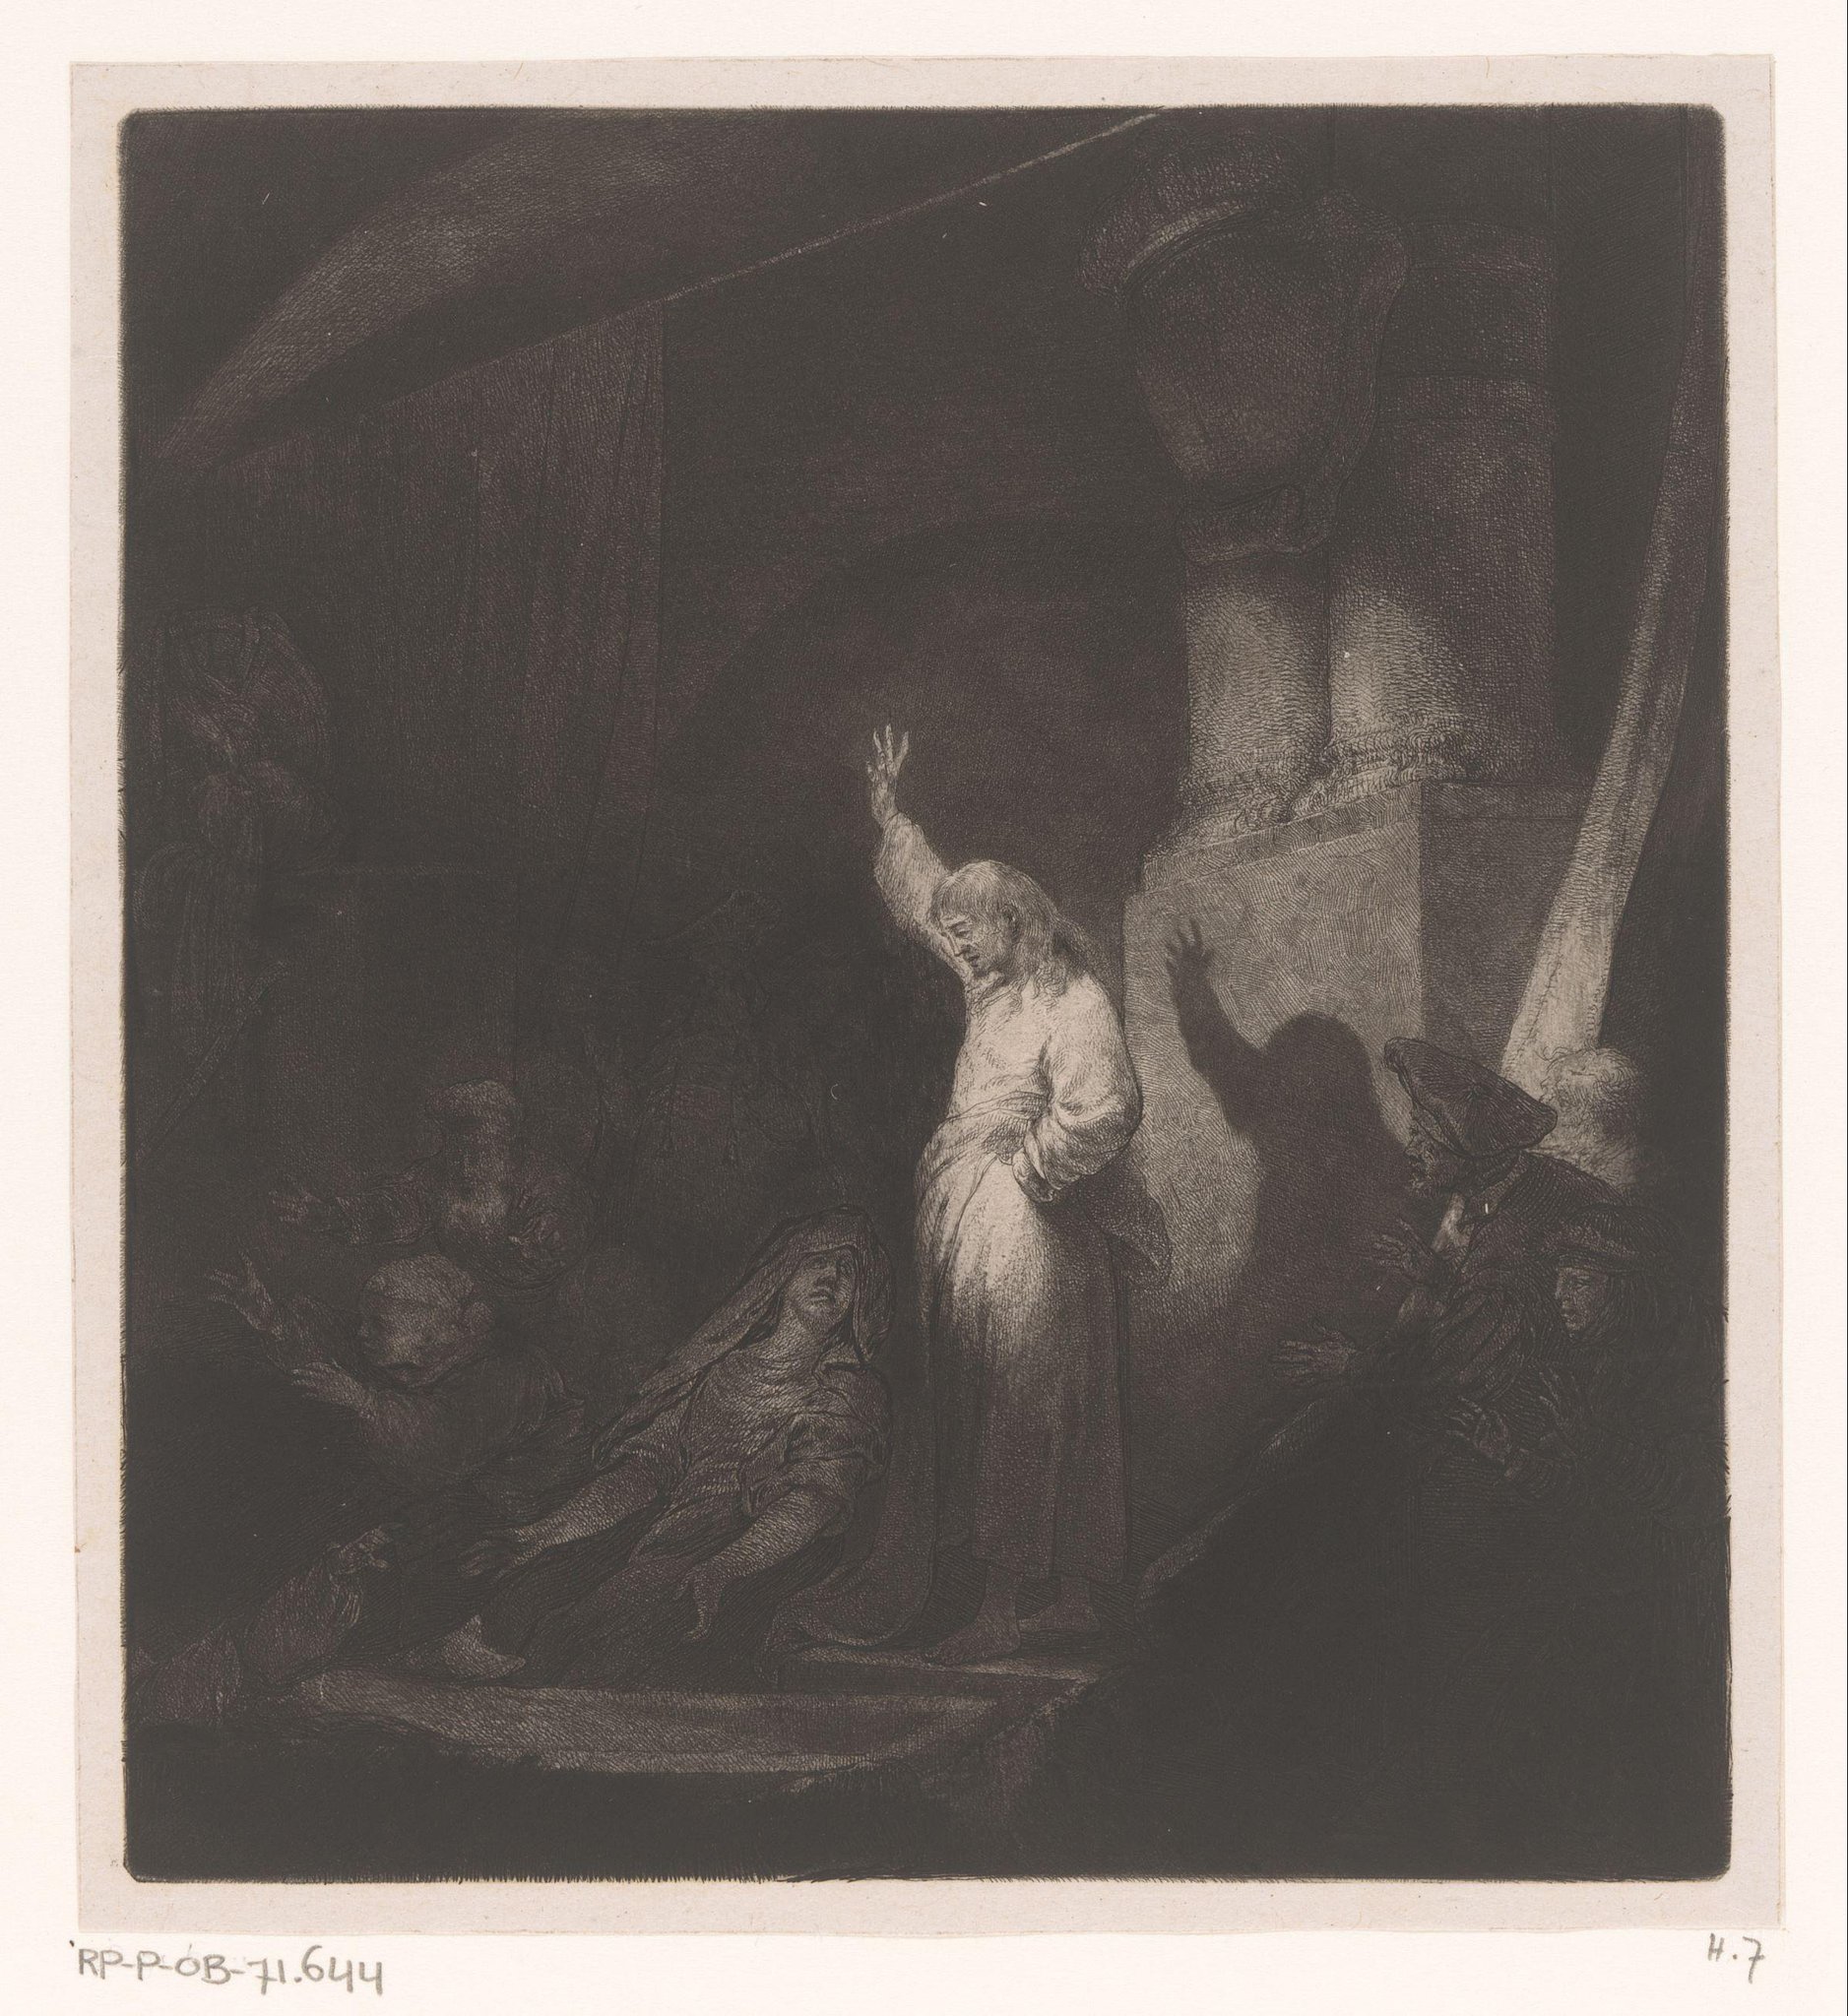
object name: print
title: Opwekking van Lazarus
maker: jean pierre norblin de la gourdaine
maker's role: print maker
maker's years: 1745-1830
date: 1774-1789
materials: paper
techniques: drypoint, etching, intaglio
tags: the raising of lazarus ('lazarus, come out')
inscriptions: collector's mark: Lugt 2228